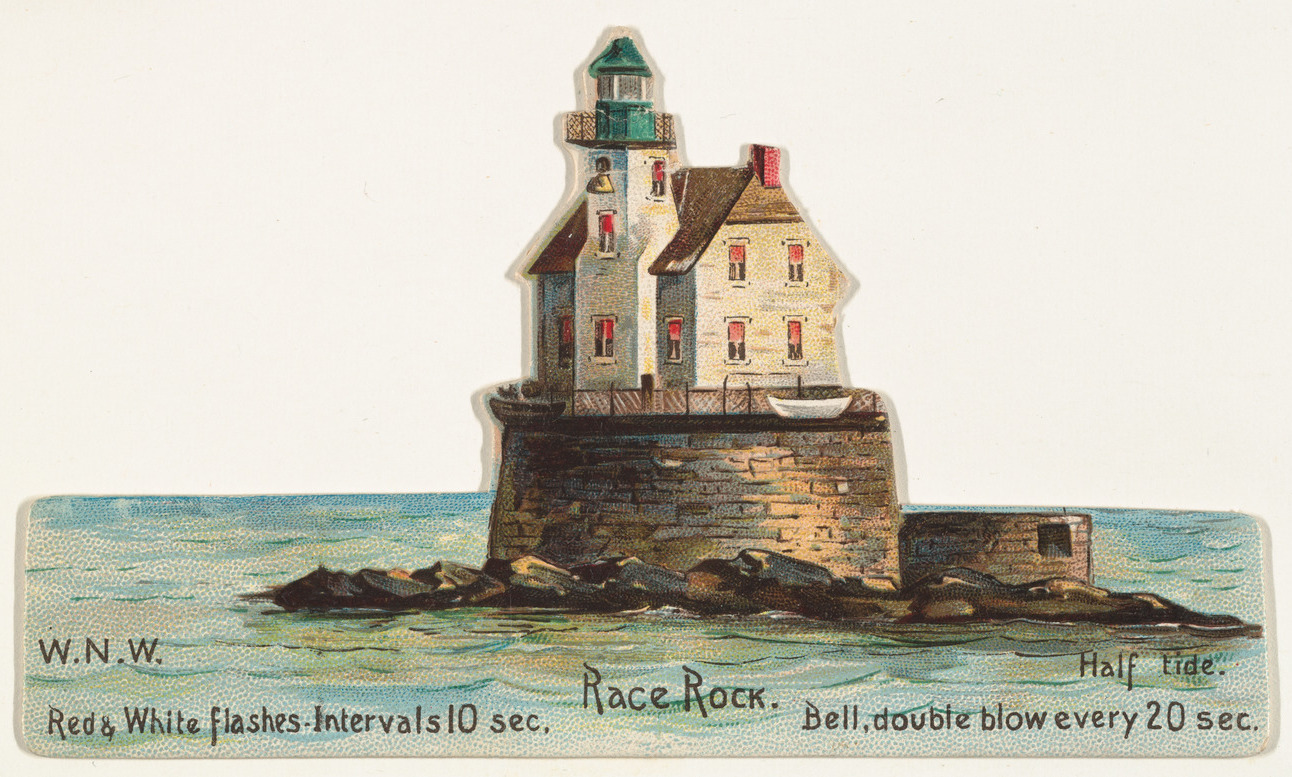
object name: print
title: Race Rock, from the Lighthouses series (N119) issued by Duke Sons & Co. to promote Honest Long Cut Tobacco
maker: w. duke, sons & co.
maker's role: publisher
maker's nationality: american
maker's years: 1870-1920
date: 1889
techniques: color lithograph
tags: lighthouses